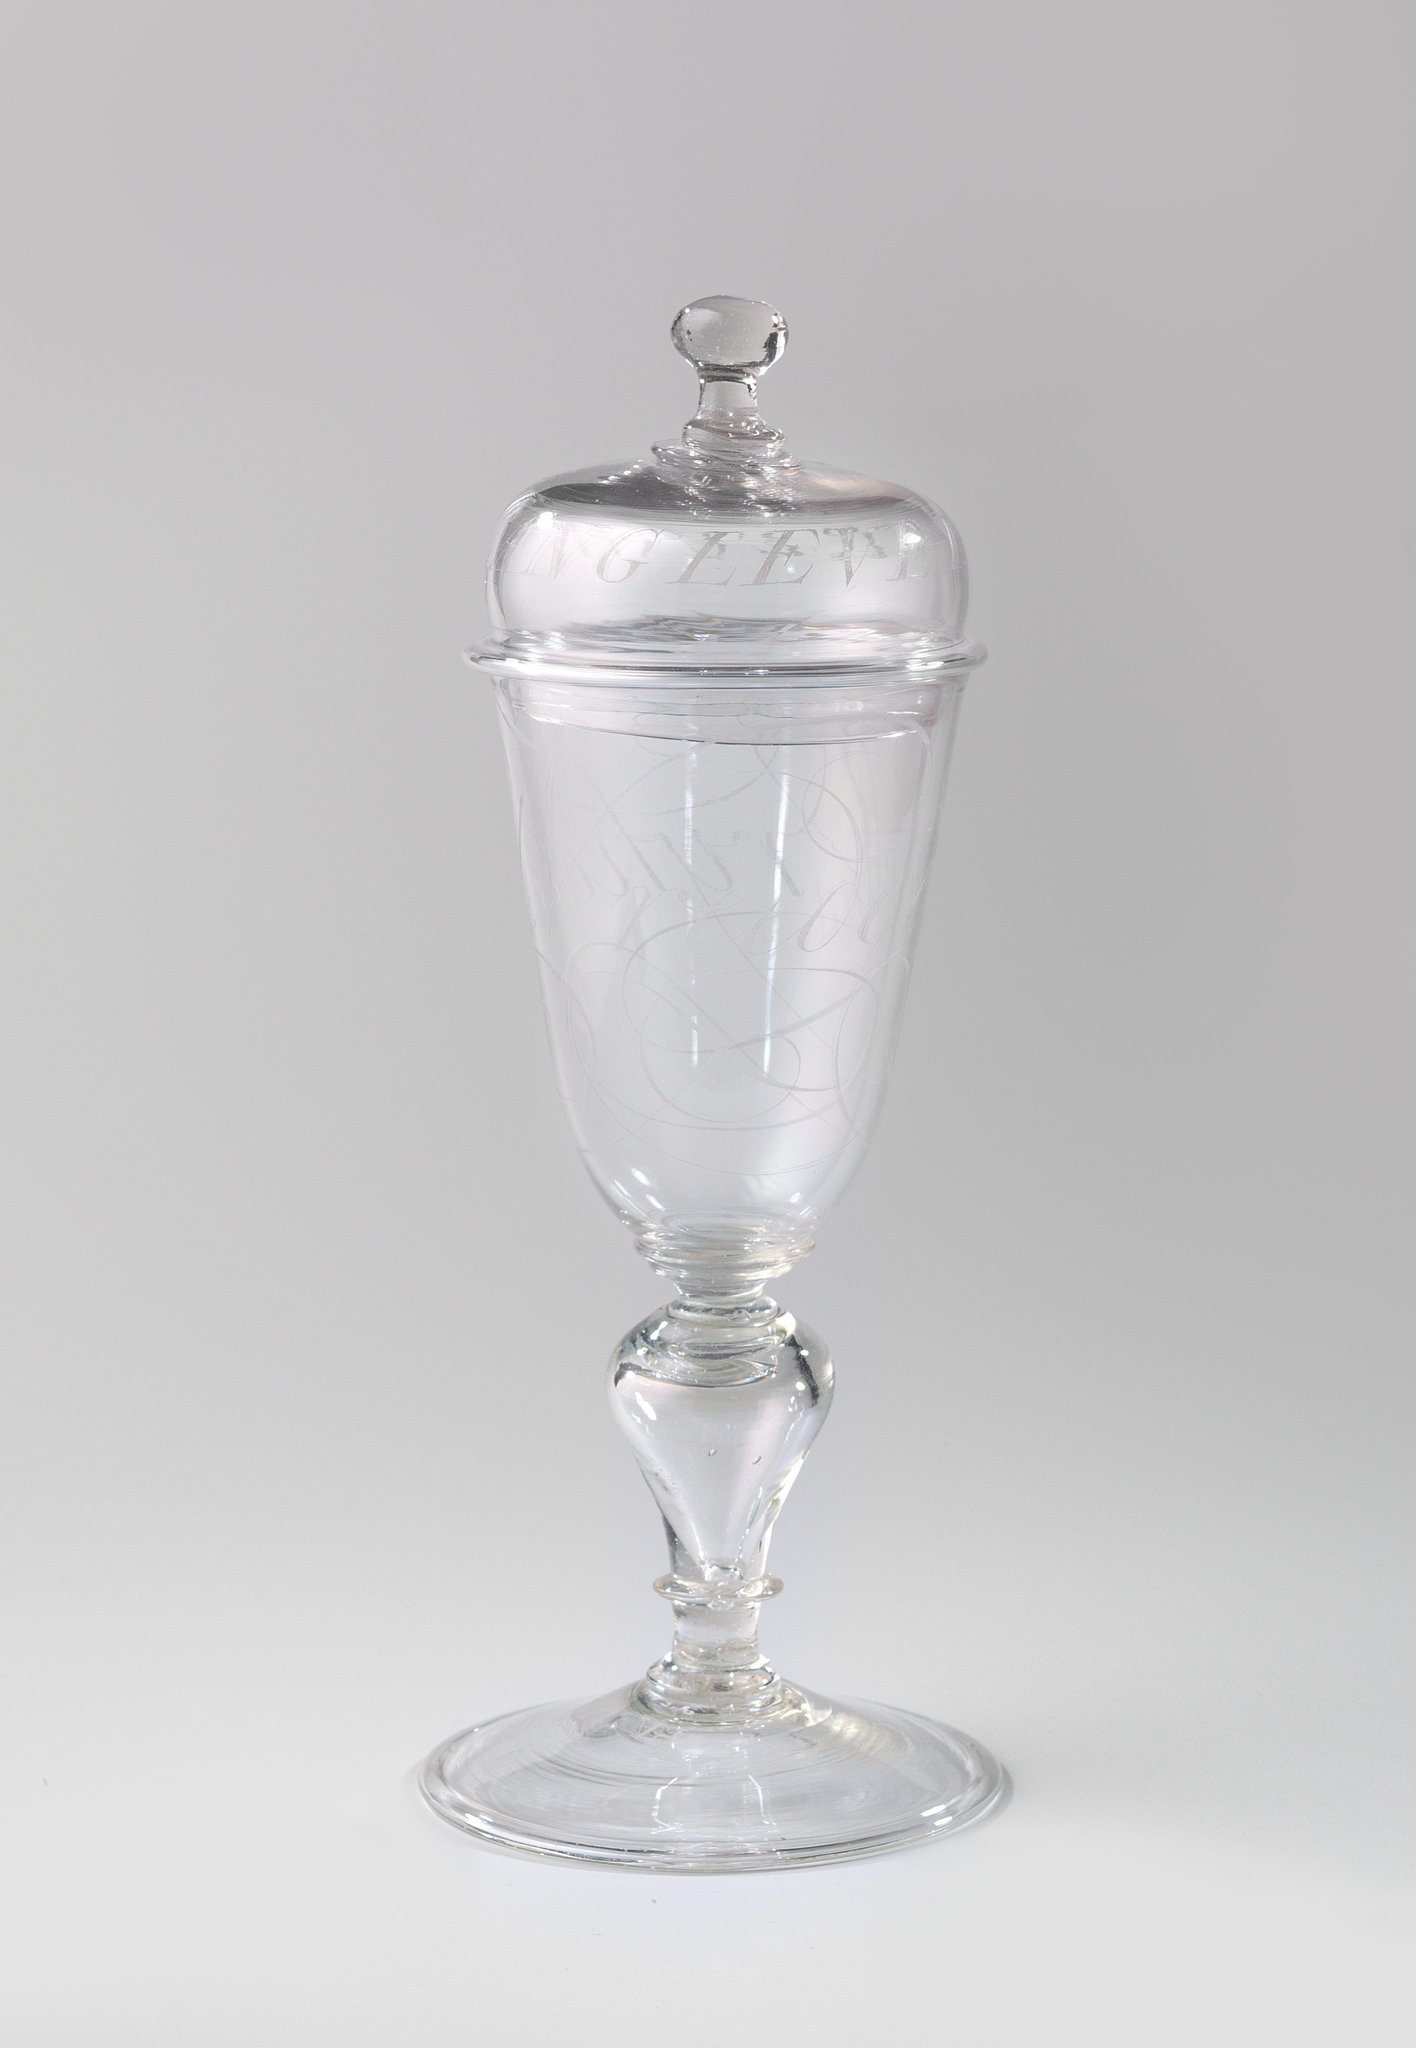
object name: goblet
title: Bokaal met deksel, met het opschrift: Vreede en Vryheid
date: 1670-1700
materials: glass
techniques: diamond point engraving, façon de venise, glassblowing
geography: northern netherlands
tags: w. post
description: Platte voet met omgeslagen rand. Holle balusterstam met een schijf. Gewelfd deksel met een bolvormige knop. Op de conische kelk het gekalligrafeerd opschrift: Vreede en Vryheid. Op de onderzijde van de voet het monogram AMvS.